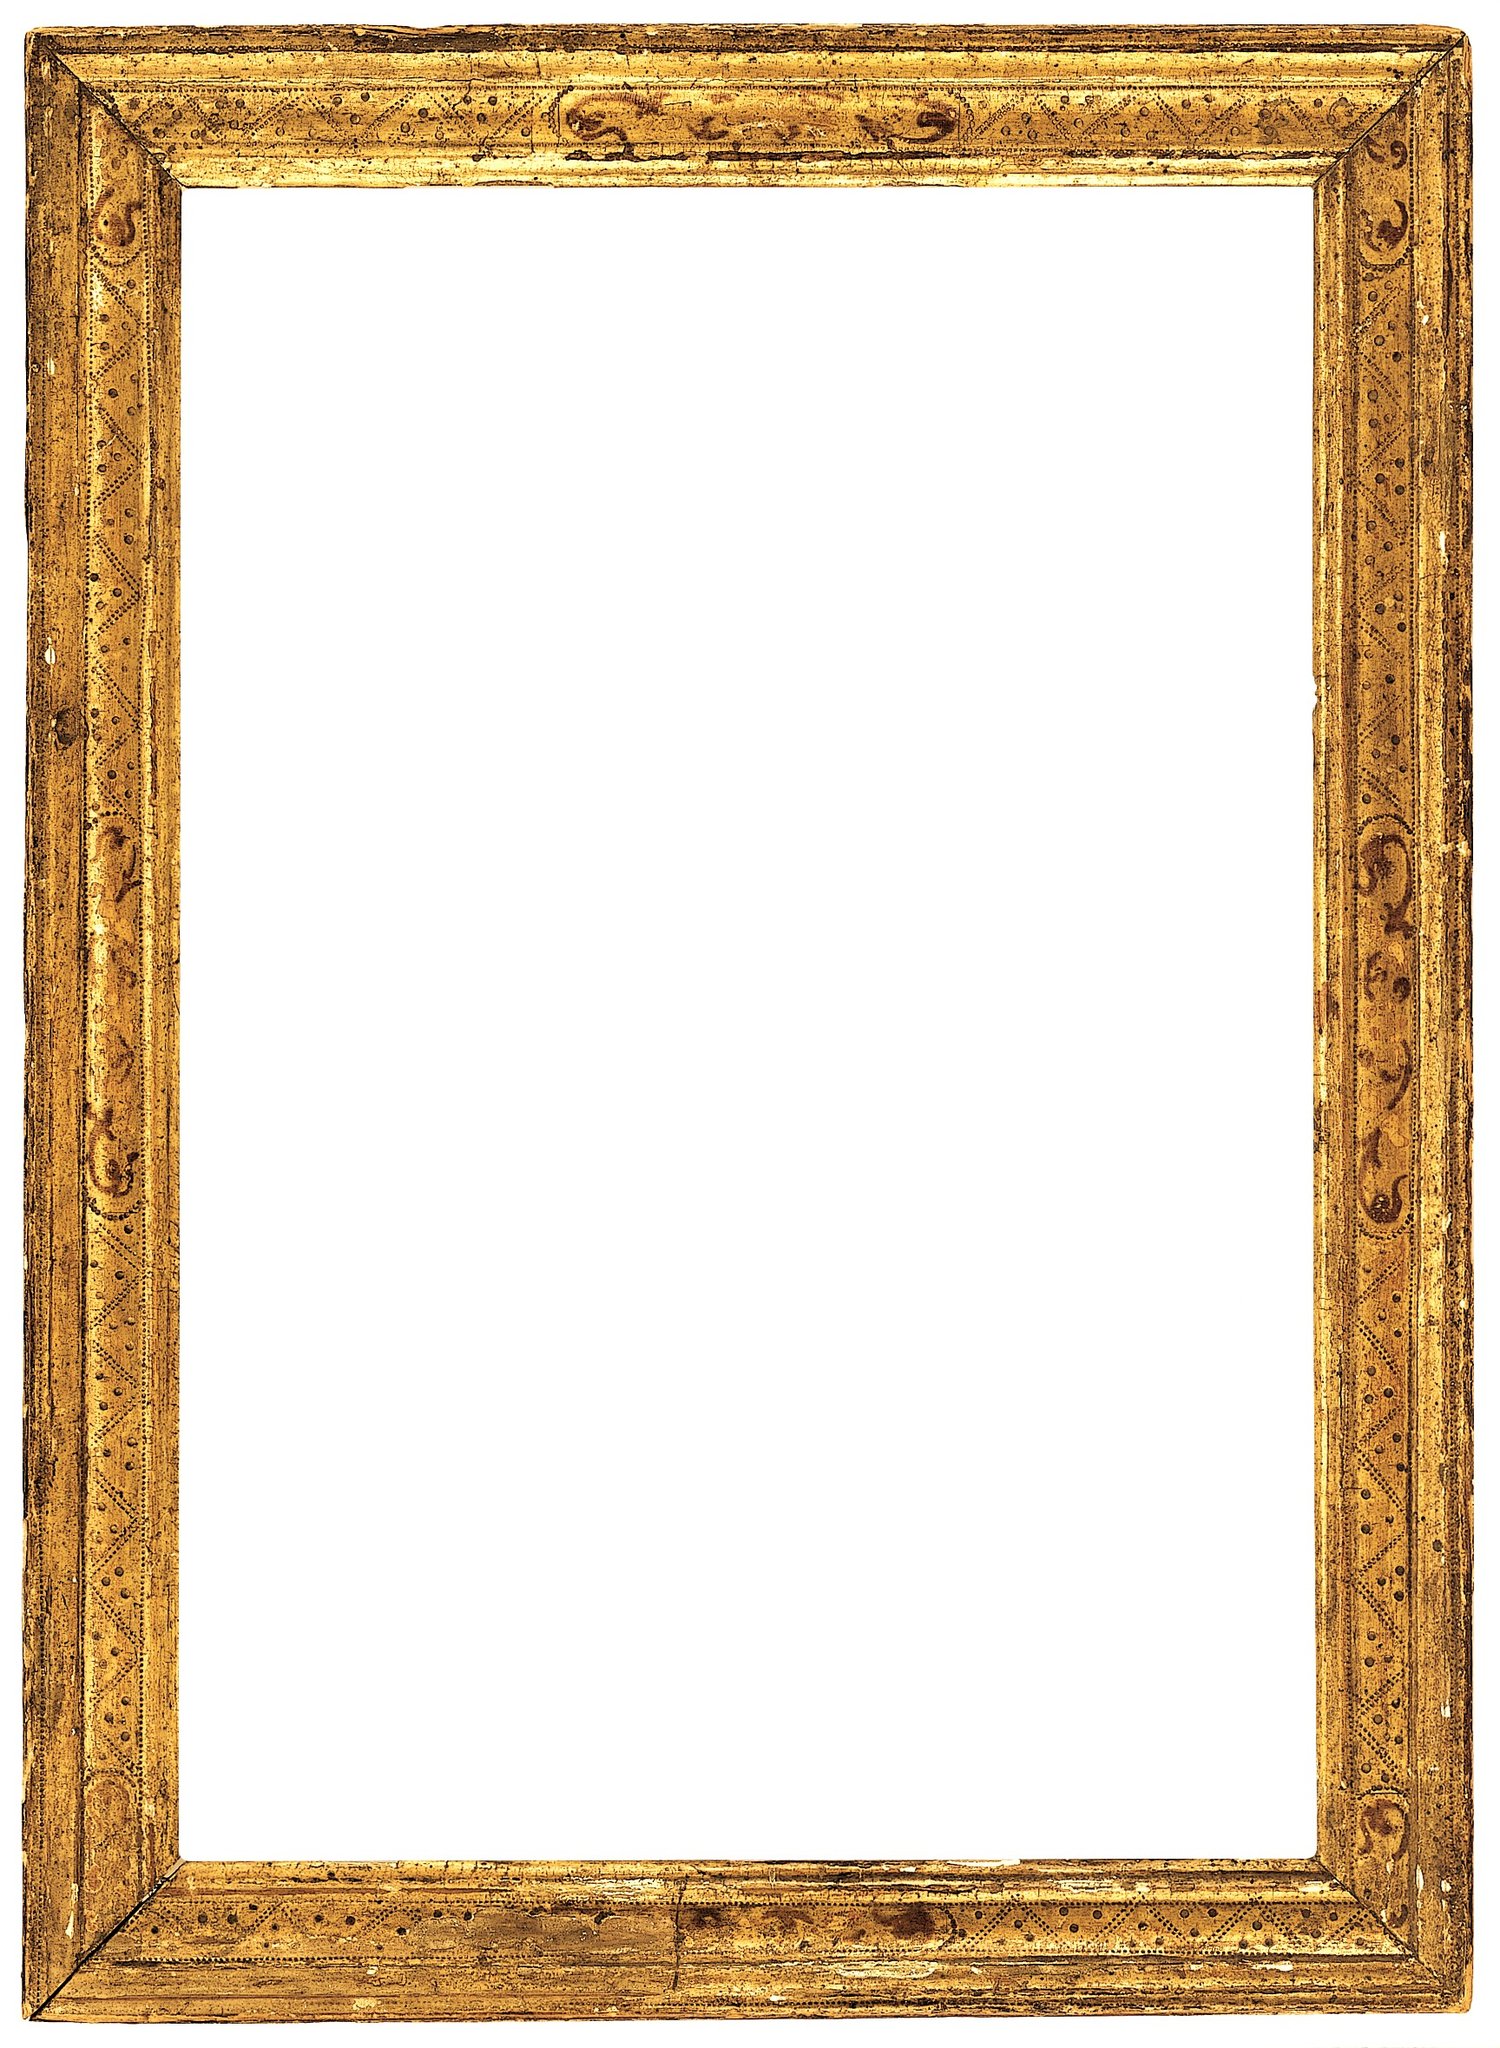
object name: frame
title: Cassetta frame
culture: italian, veneto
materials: wood